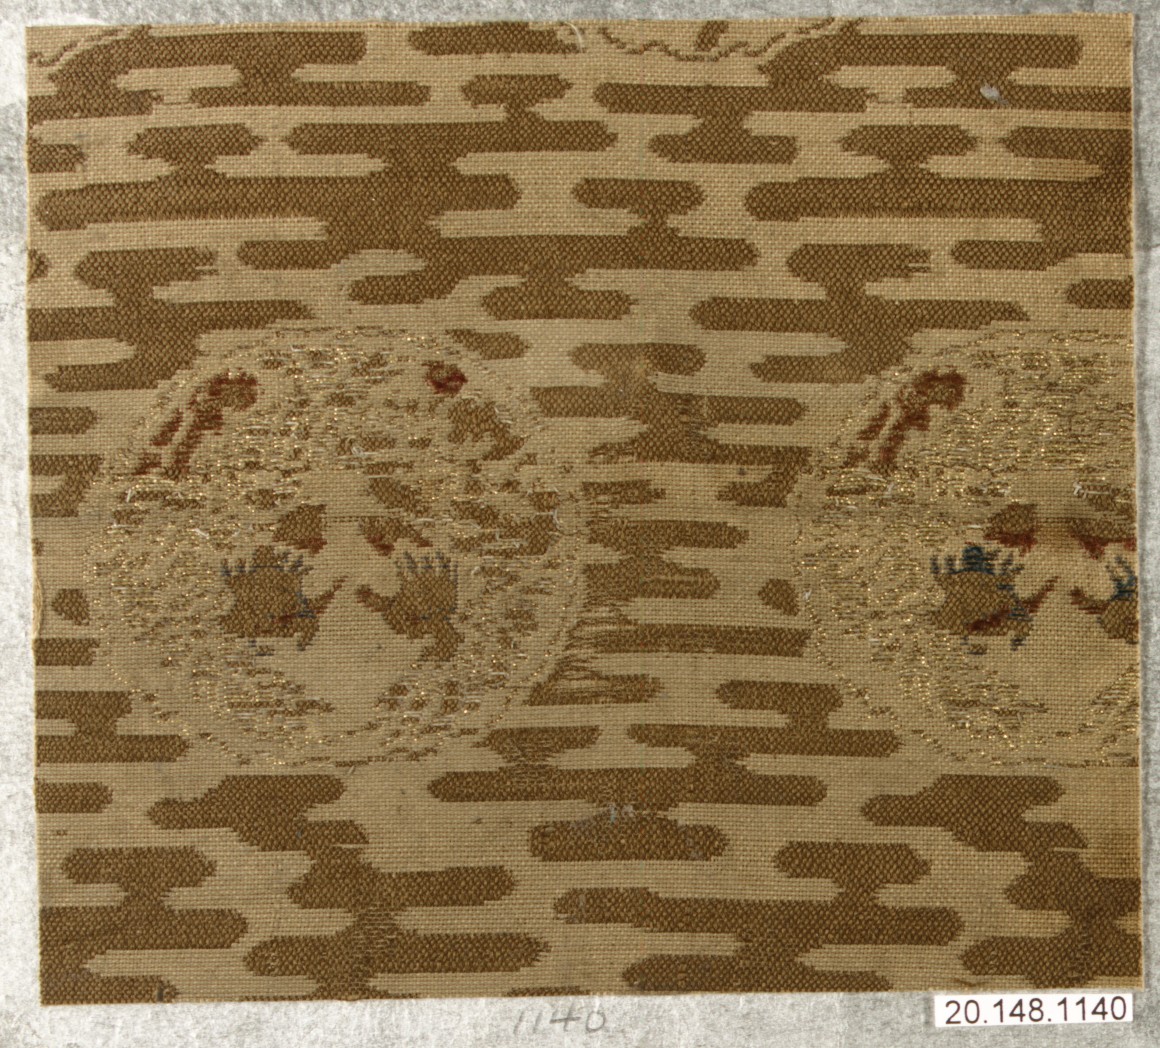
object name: piece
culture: japanese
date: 1701-1800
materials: silk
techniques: compound weave